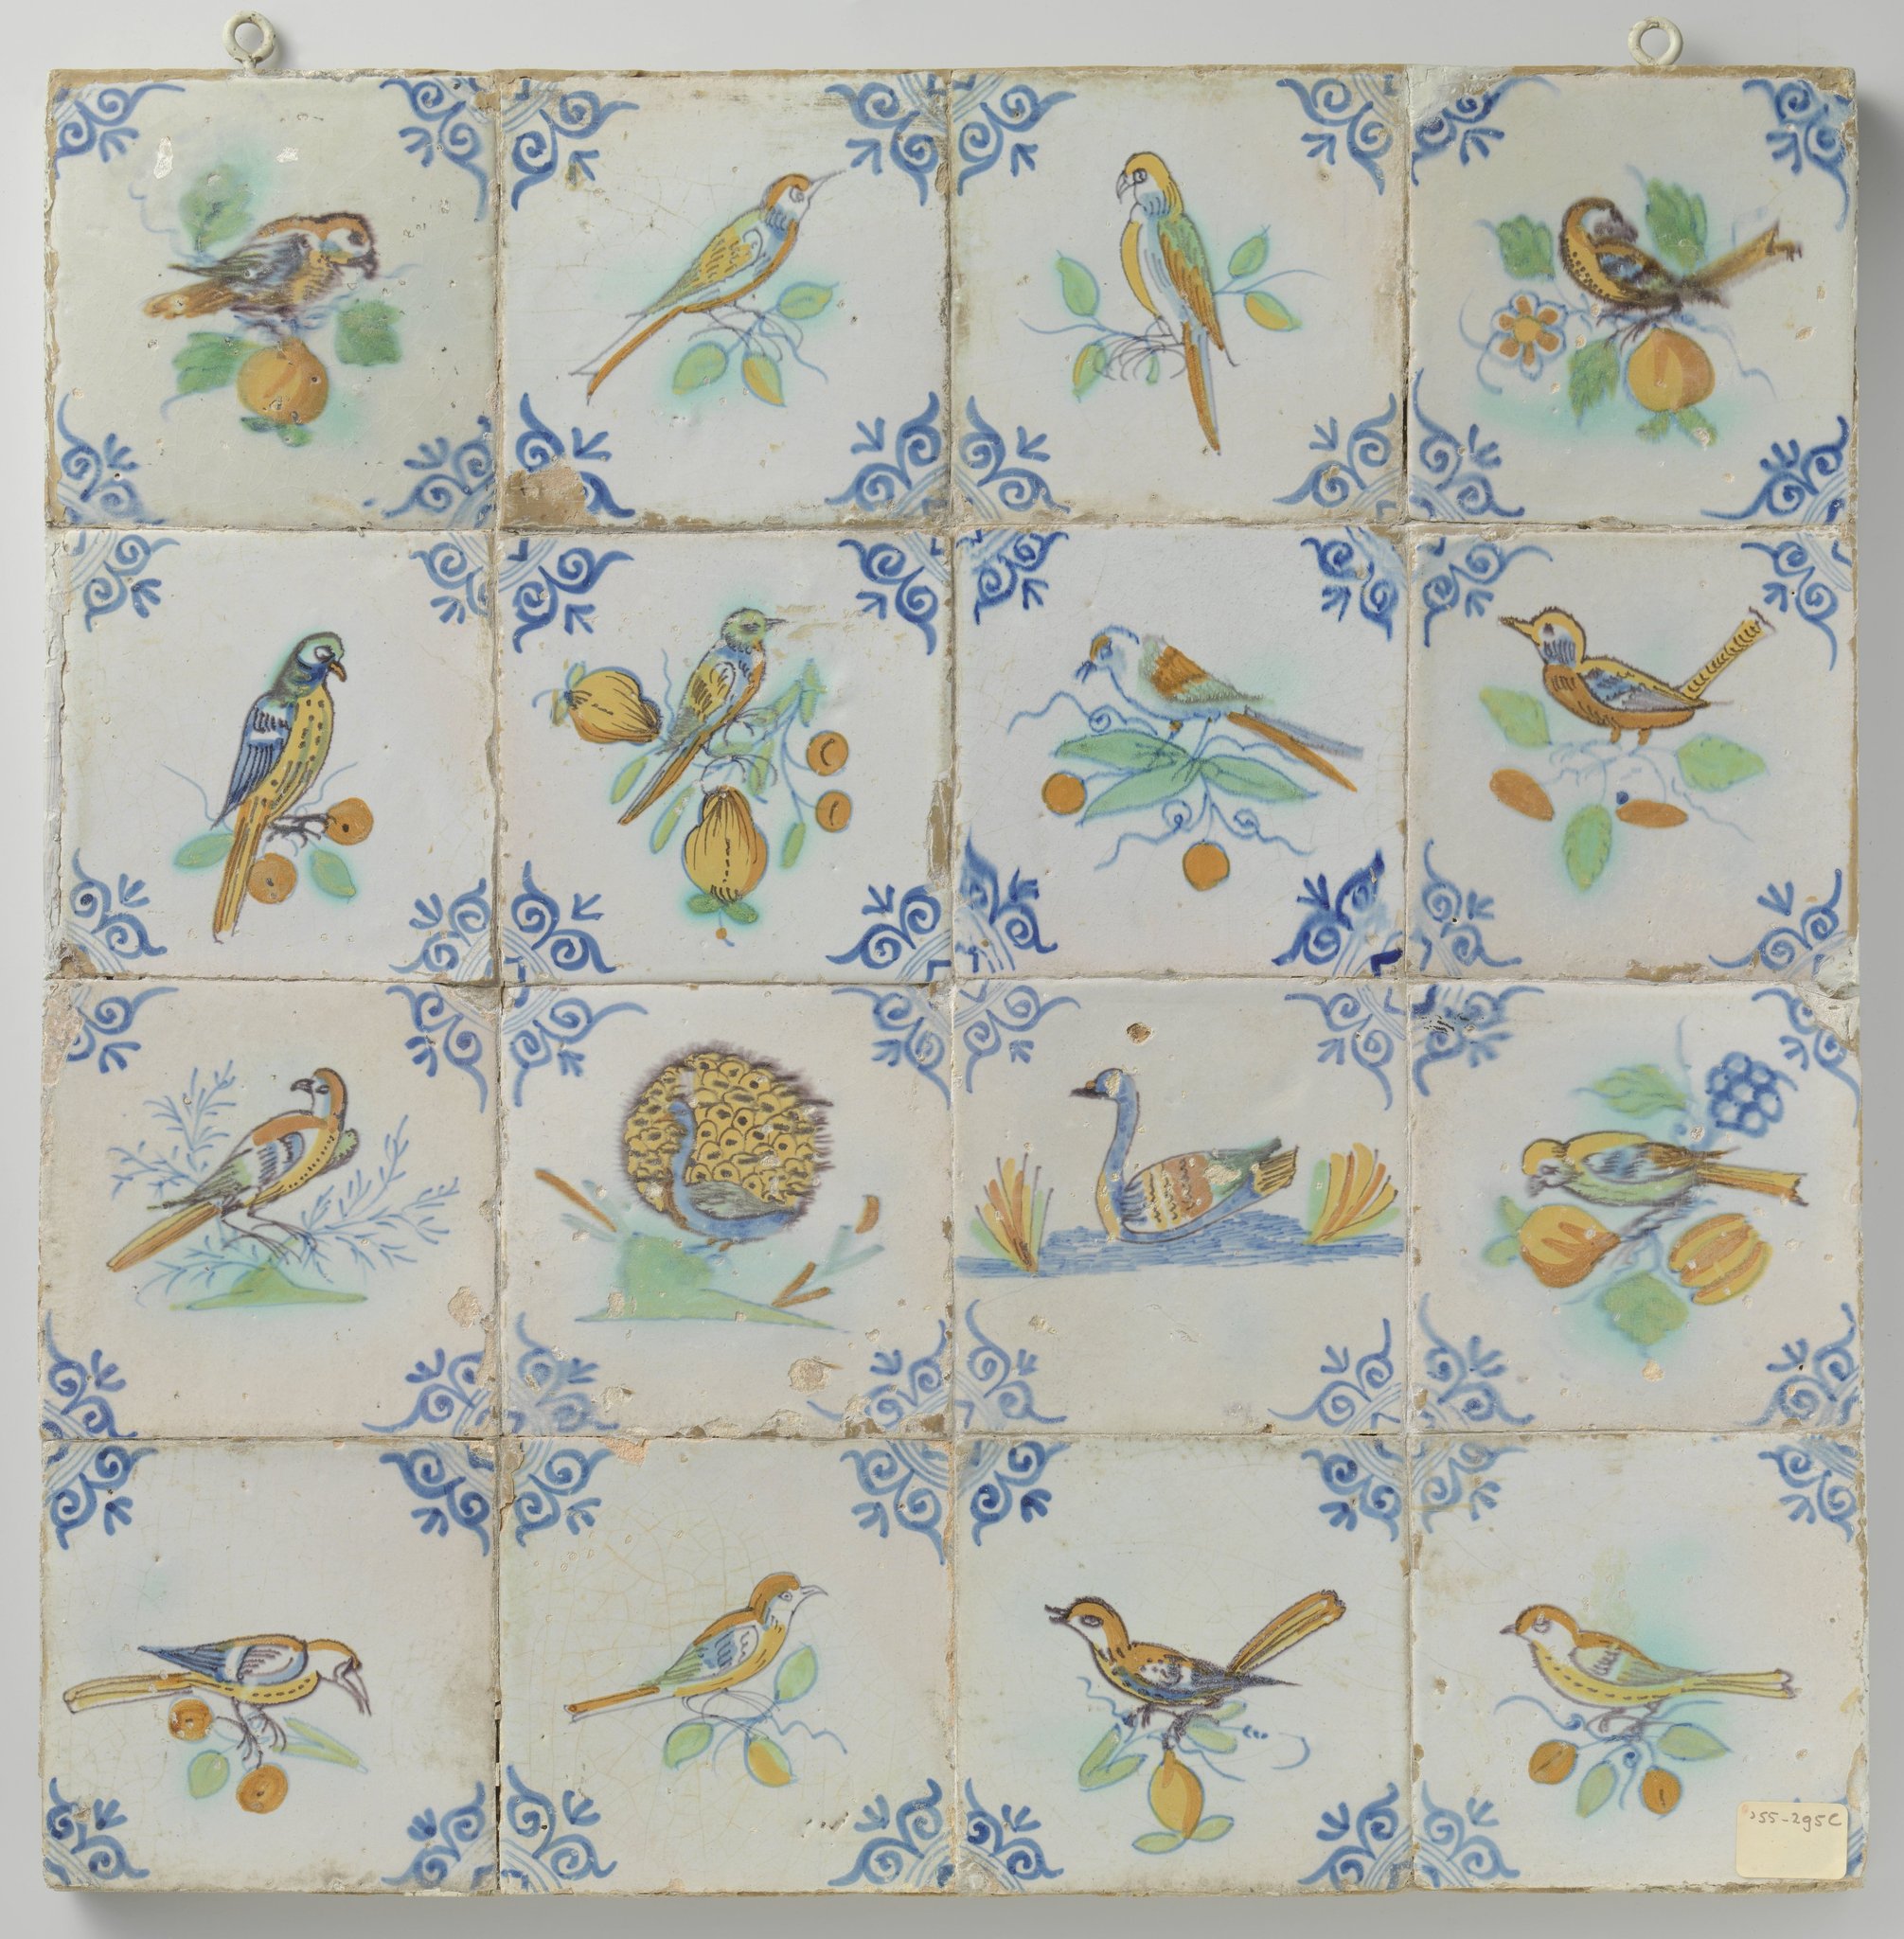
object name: tile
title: Veld van zestien tegels met vogels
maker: Anonymous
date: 1640-1660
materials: earthenware, glaze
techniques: maiolica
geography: netherlands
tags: birds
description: Veld van zestien tegels (4 x 4) elk met een veelkleurige (blauw, groen, geel, oranje en paars) vogel op een tak met bessen. In de hoeken, een ossekop.